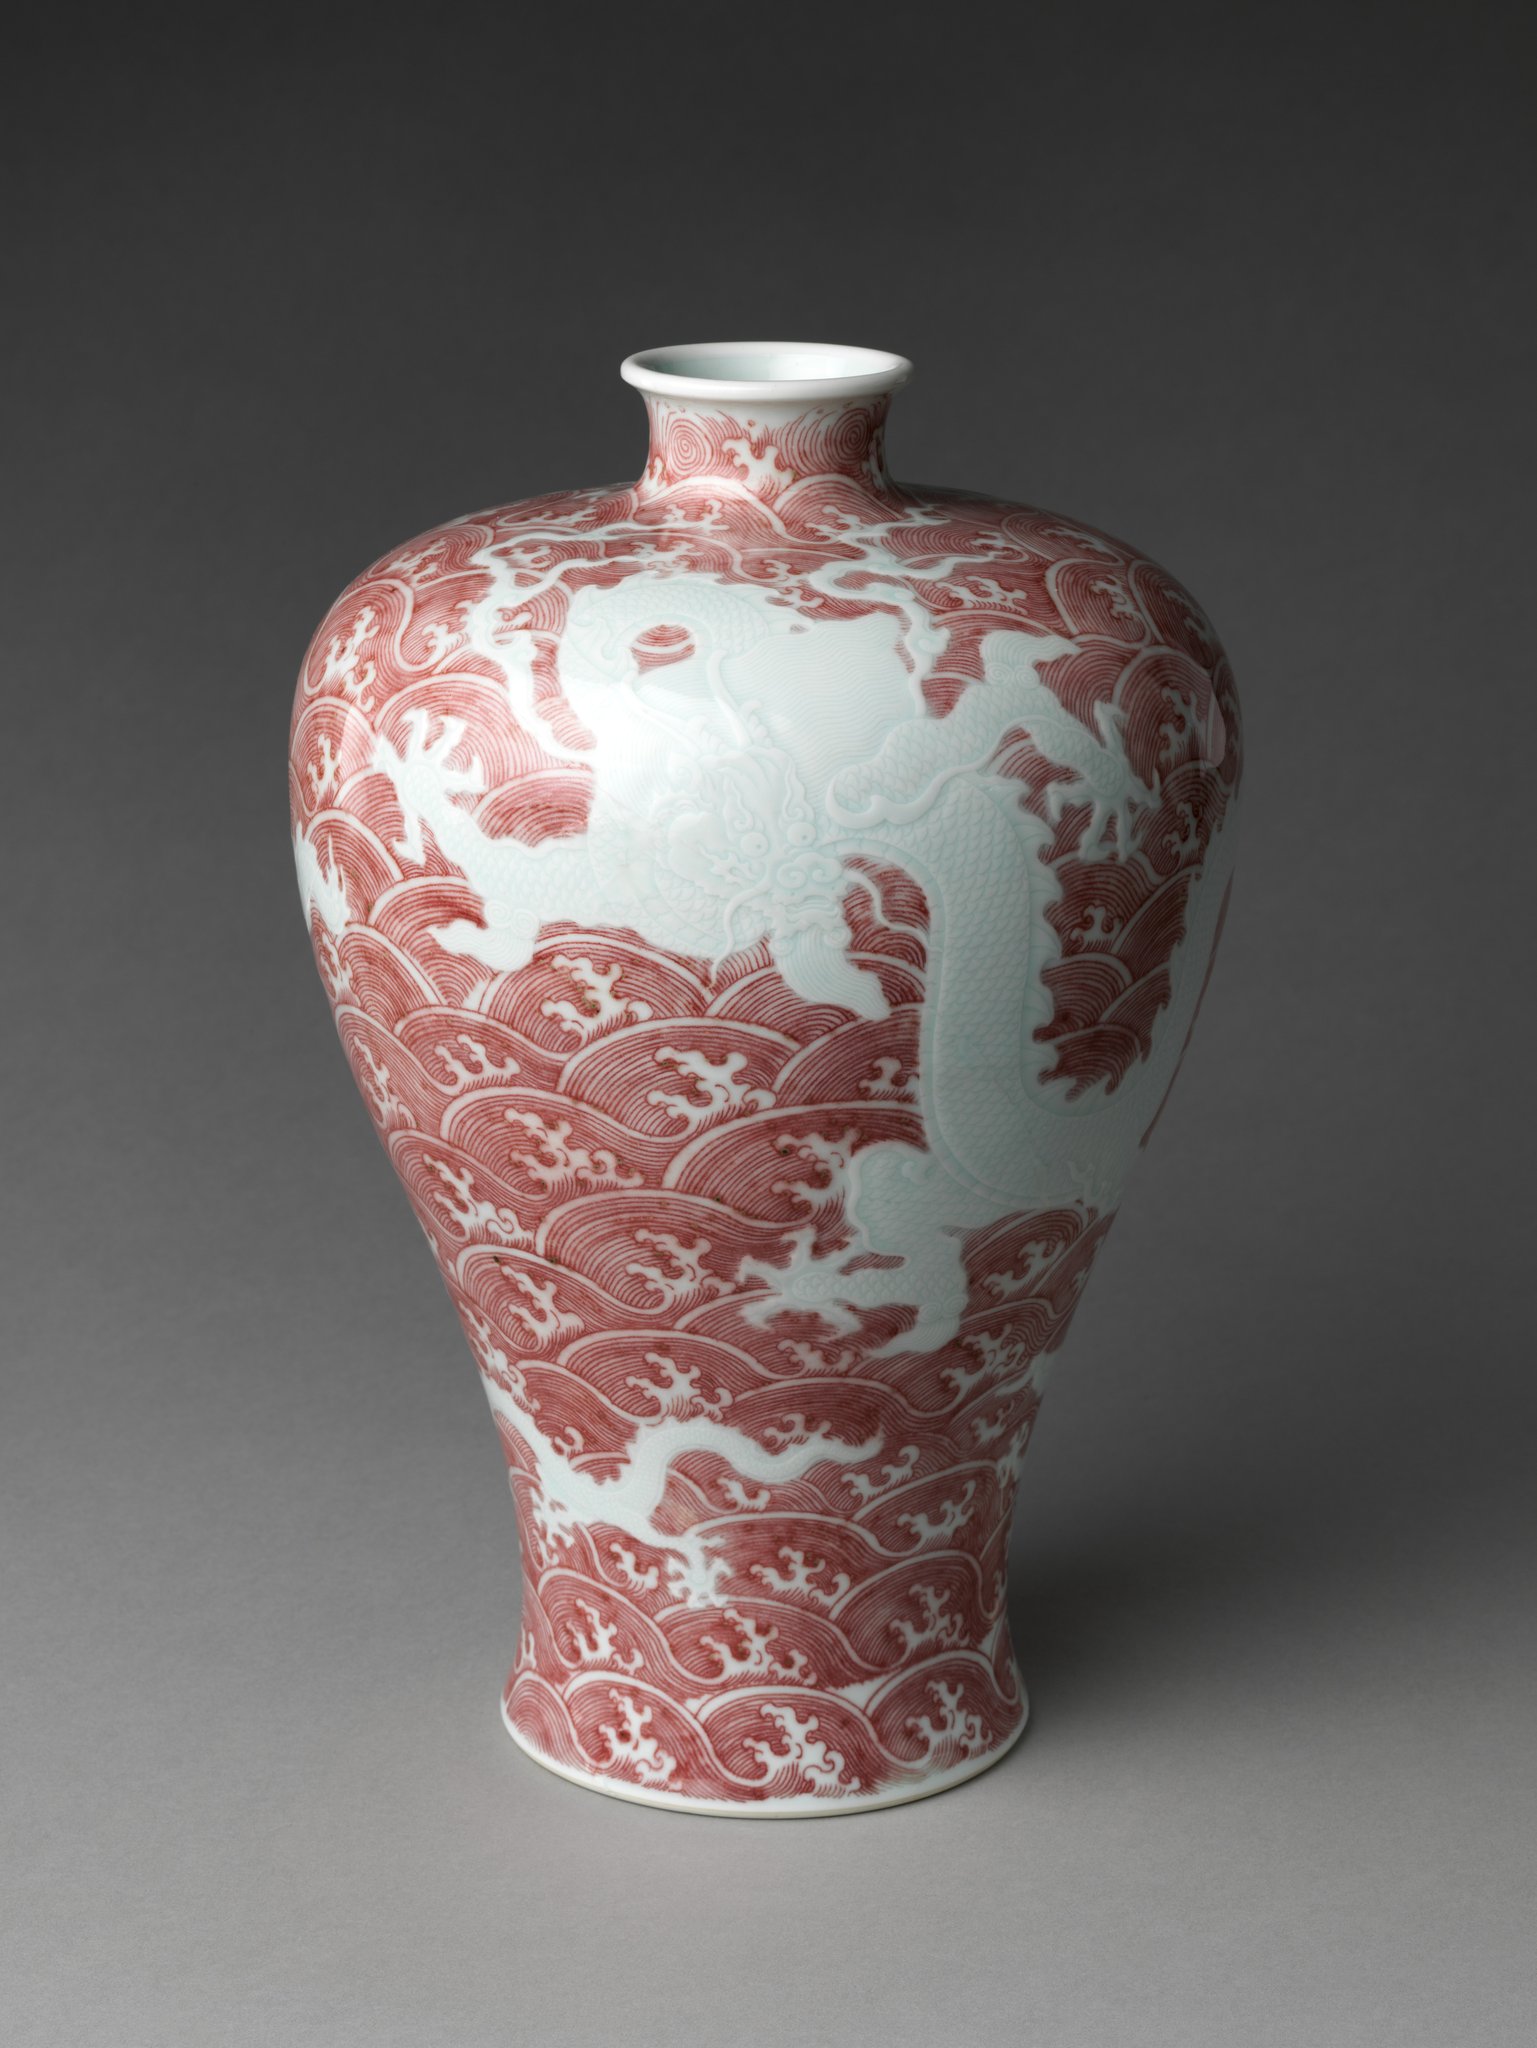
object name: vase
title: Vase with Dragons and Waves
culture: chinese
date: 1723-1735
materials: glaze, porcelain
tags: dragons,waves